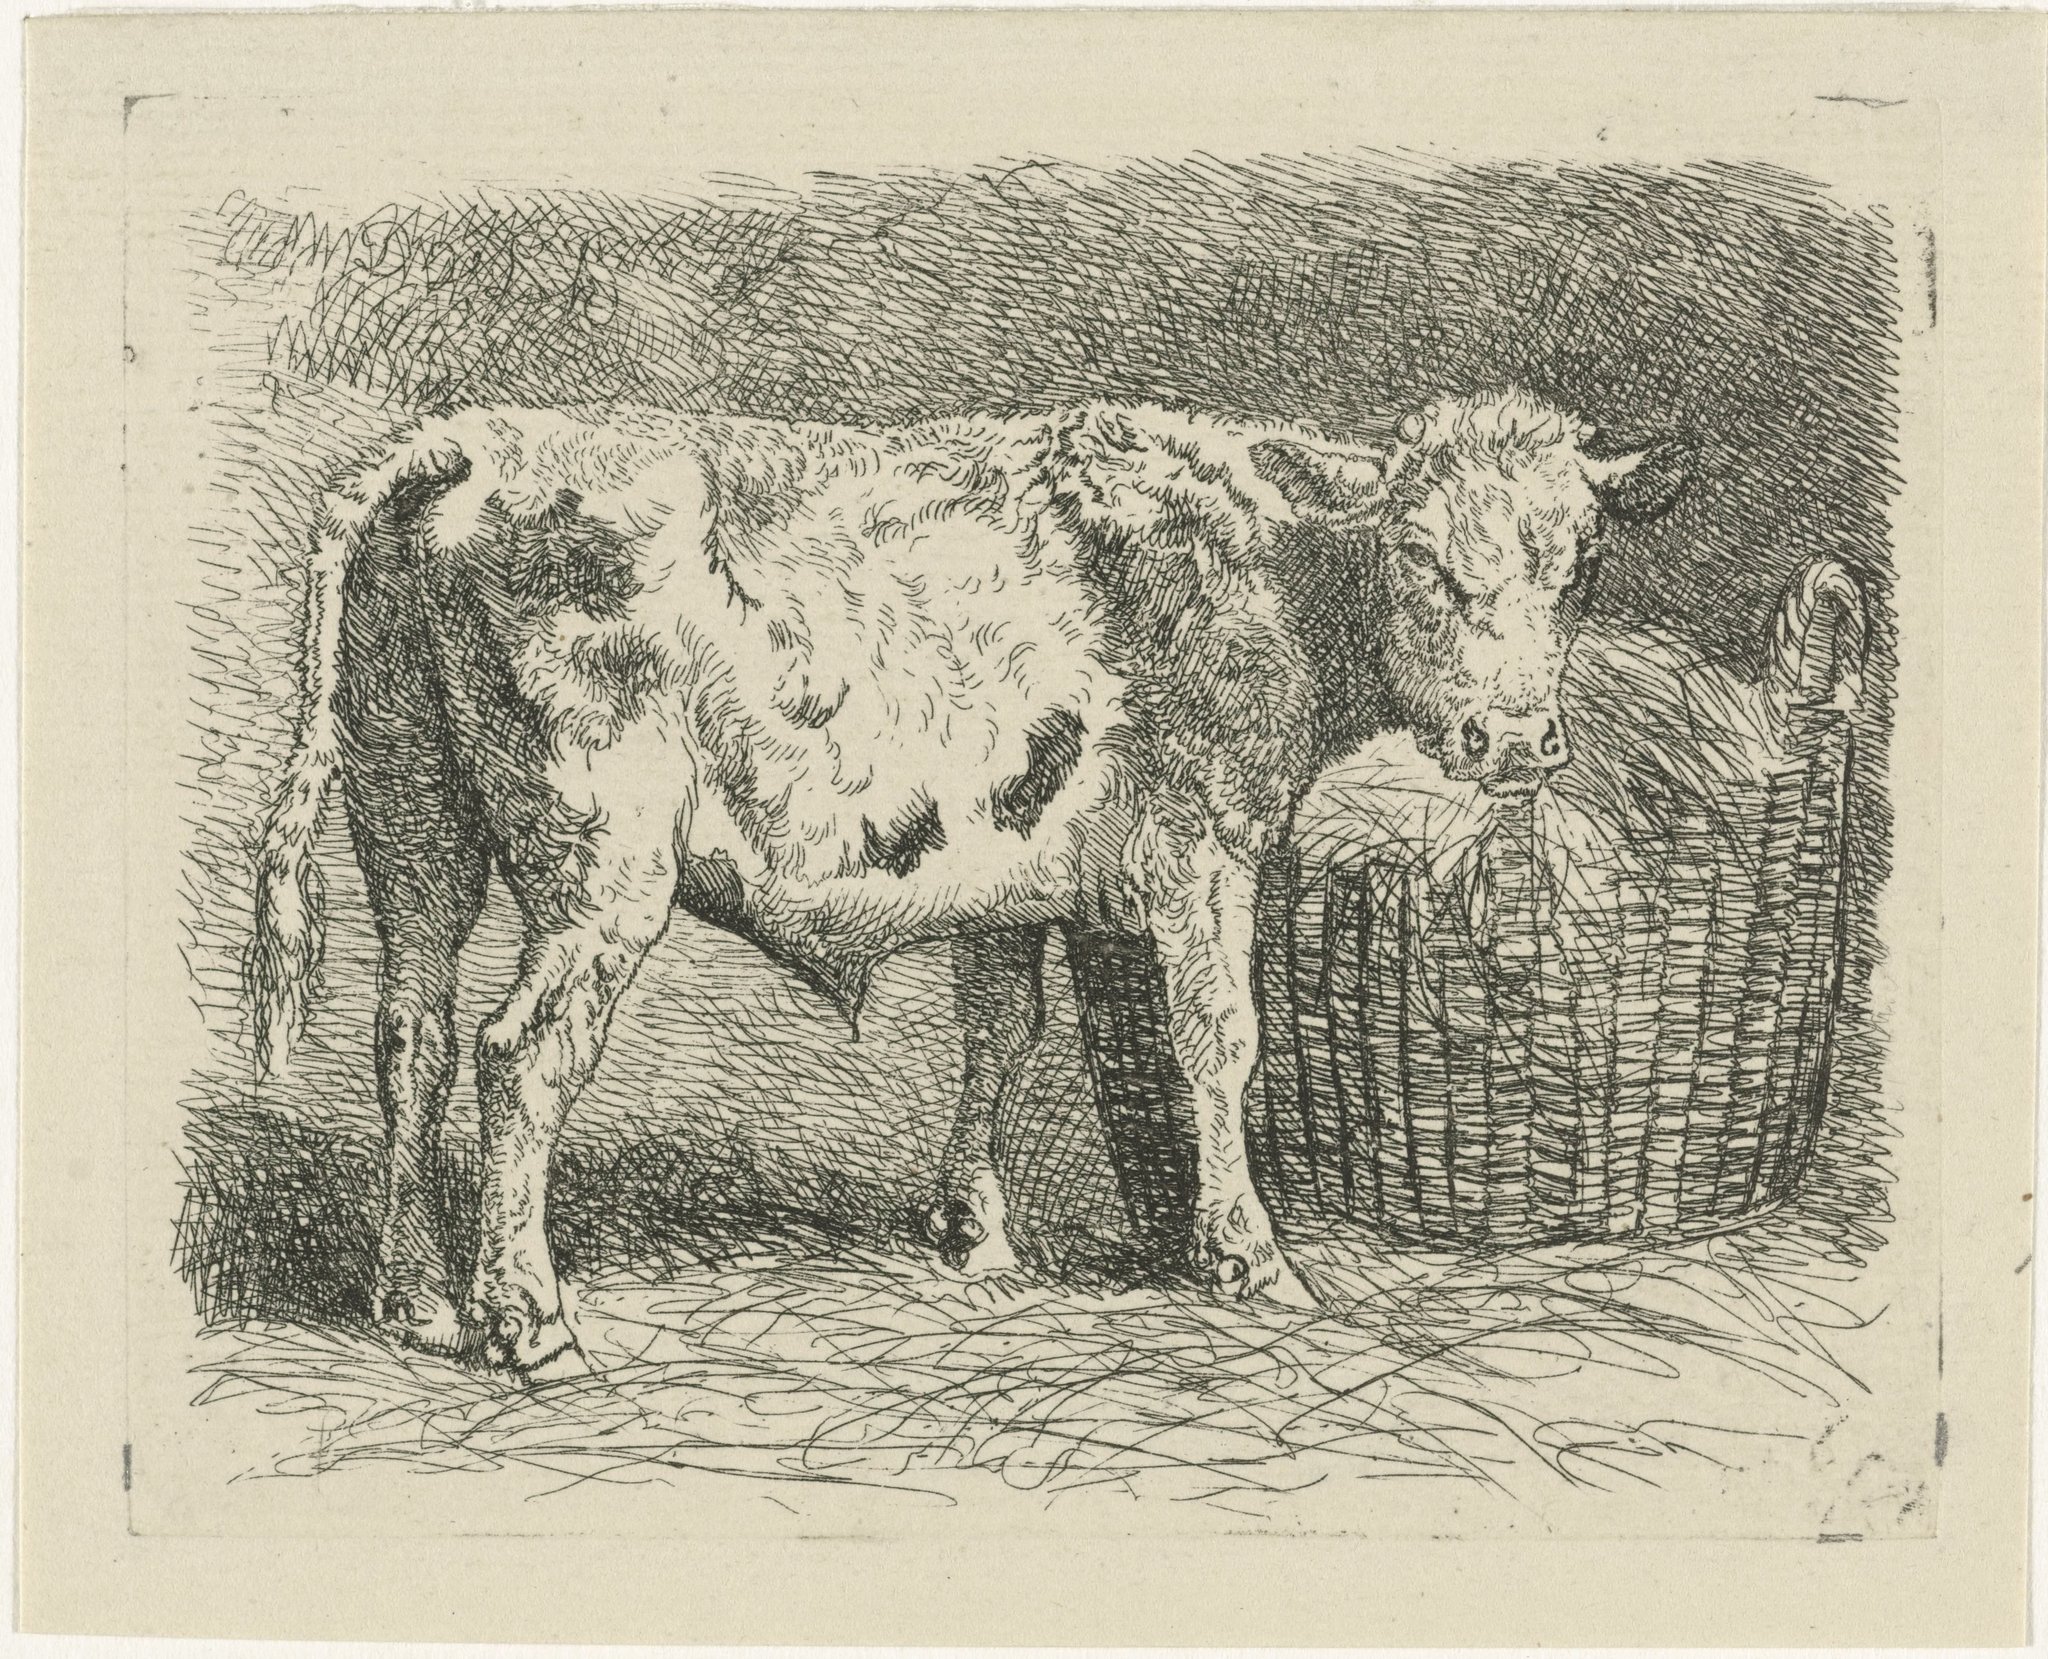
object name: print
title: Jonge stier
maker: dirk van lokhorst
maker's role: draughtsman, painter, print maker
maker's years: 1818-1893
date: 1828-1886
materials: paper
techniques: etching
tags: bull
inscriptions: collector's mark: Lugt 2228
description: Een jonge stier etend uit een mand met hooi.